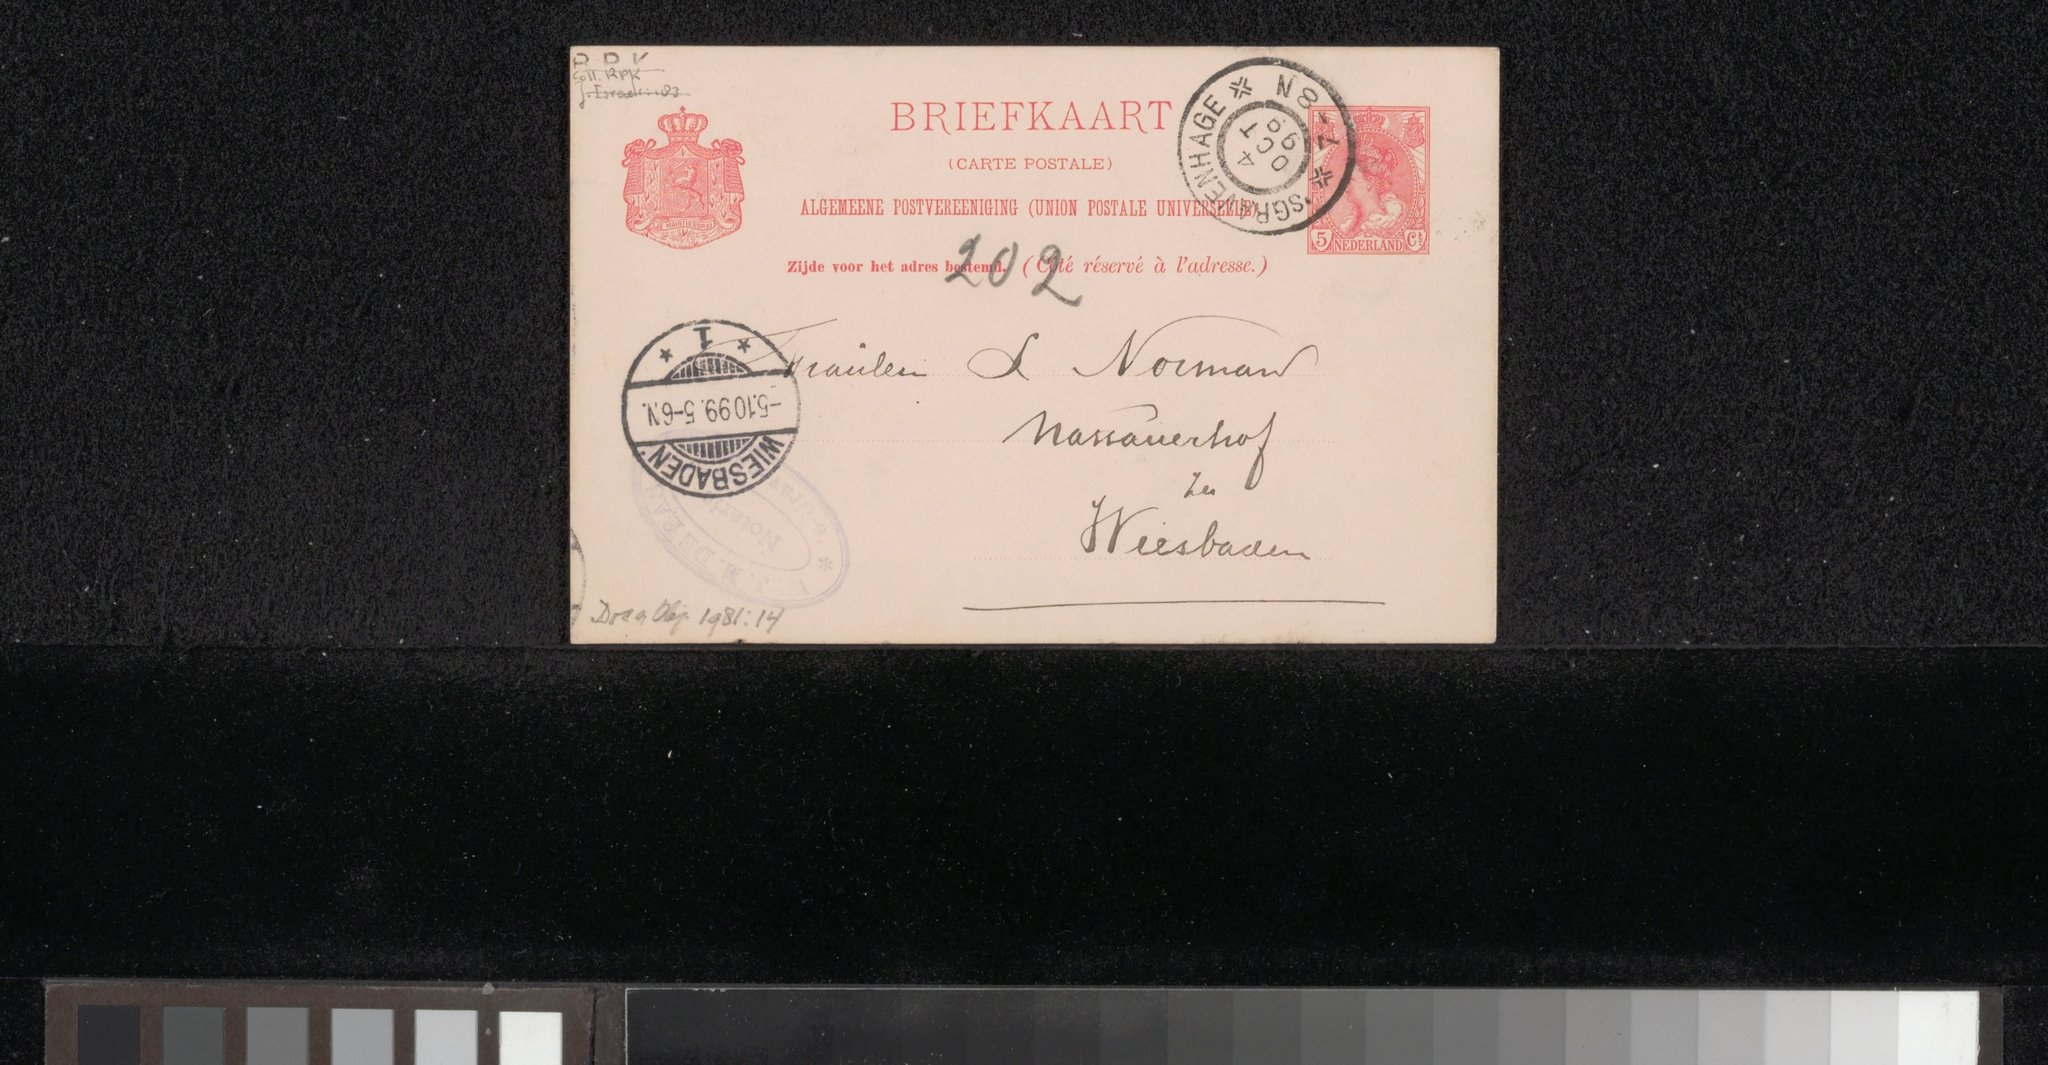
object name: postcard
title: Briefkaart aan Betsy Norman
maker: jozef israëls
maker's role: draughtsman, painter, print maker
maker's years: 1824-1911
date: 1899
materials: cardboard, ink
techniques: pen, writing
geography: the hague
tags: rotterdam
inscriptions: collector's mark: ‘RPK’